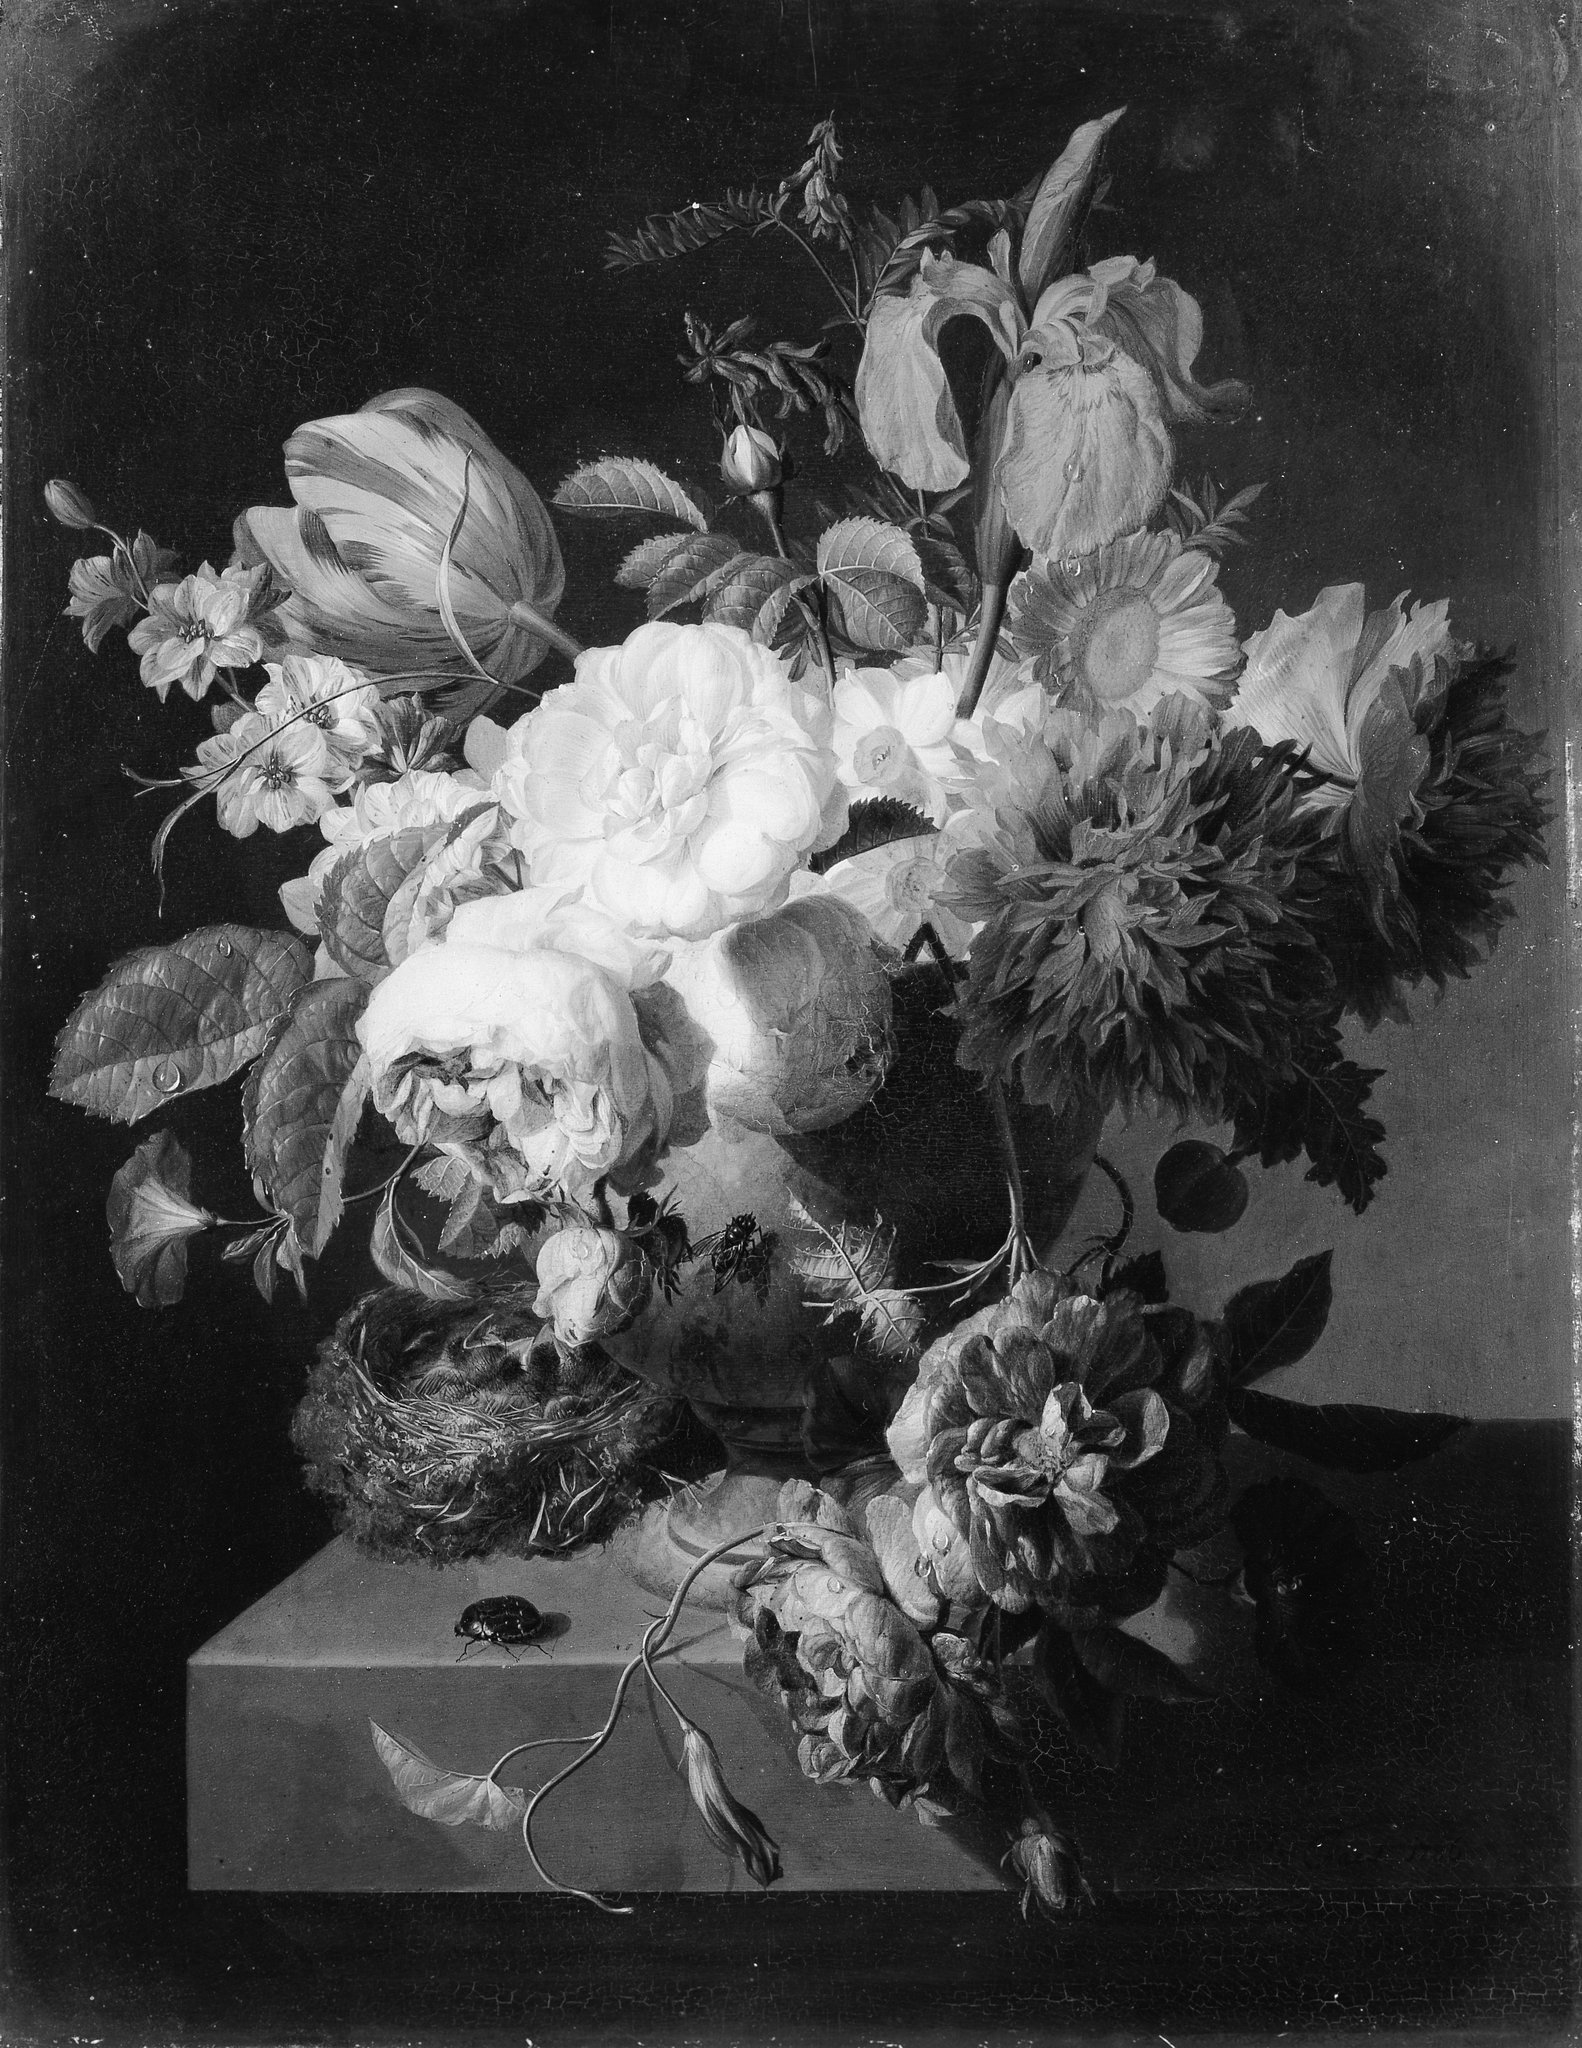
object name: painting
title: Flowers in a Stone Vase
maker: peter faes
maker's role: artist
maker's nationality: flemish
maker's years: 1750-1814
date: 1786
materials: oil, wood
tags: flowers,still life